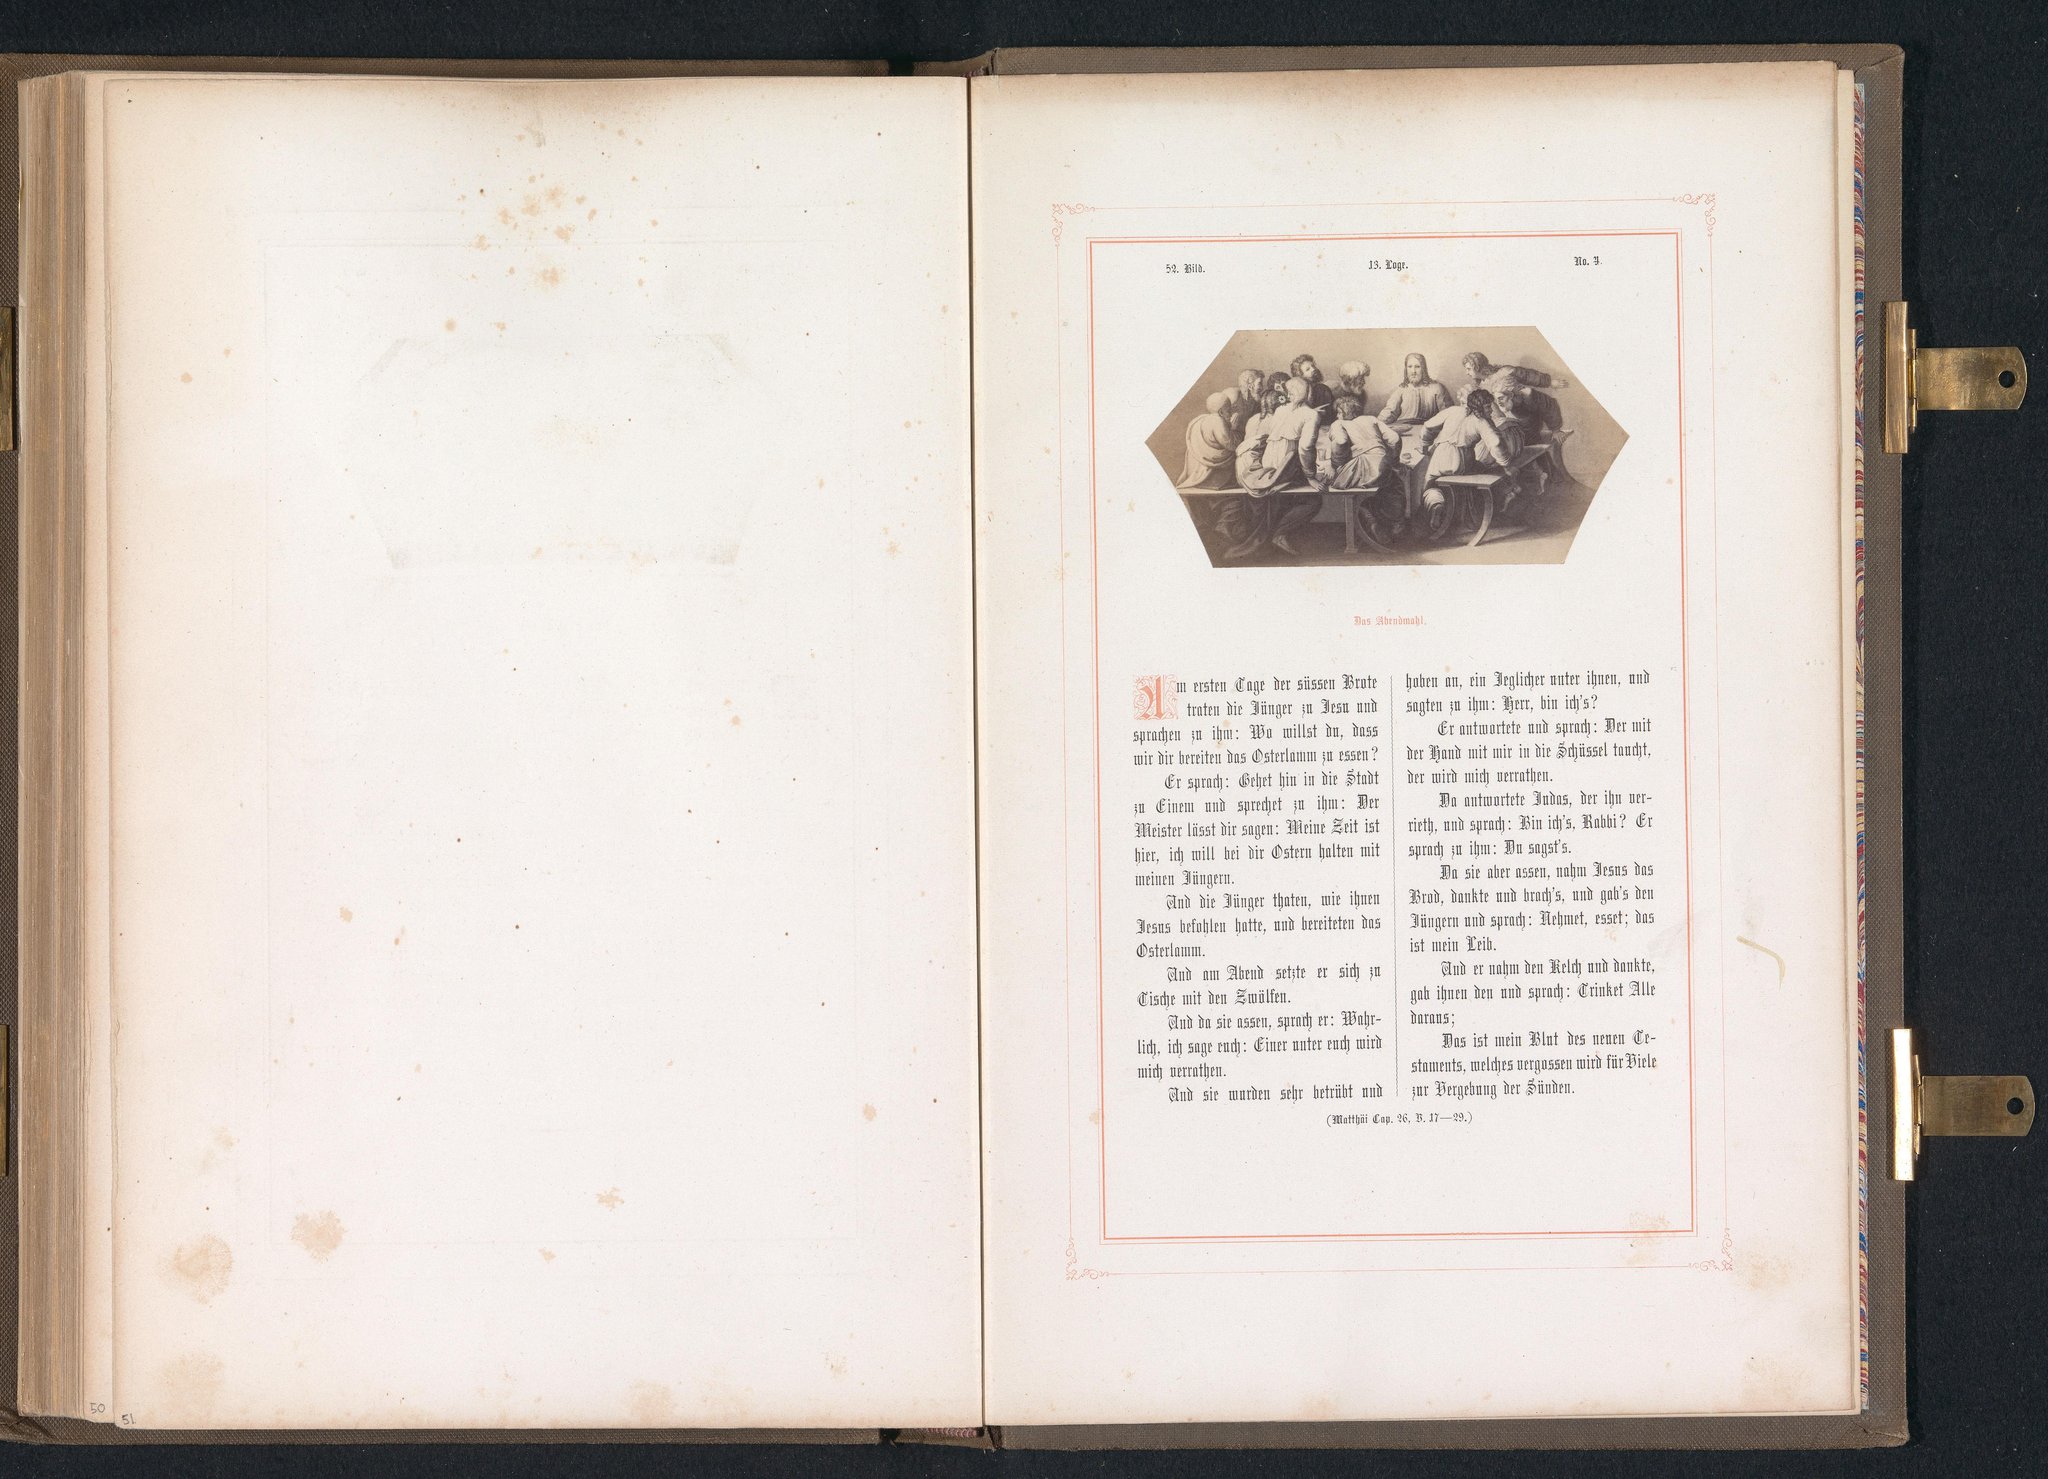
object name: page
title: Fotoreproductie van een prent naar een fresco van het Laatste Avondmaal door Rafaël voor de loggia's in het Vaticaan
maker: gustav schauer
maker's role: painter, publisher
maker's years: 1826-1902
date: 1851-1861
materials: photographic support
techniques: albumen print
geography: berlin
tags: last supper (in general) (matthew 26:21-35; mark 14:18-31; luke 22:3, 22:15-23; john 13:21-38)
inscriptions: inscription: ‘52. Bild. 13. Loge. No. 4.’